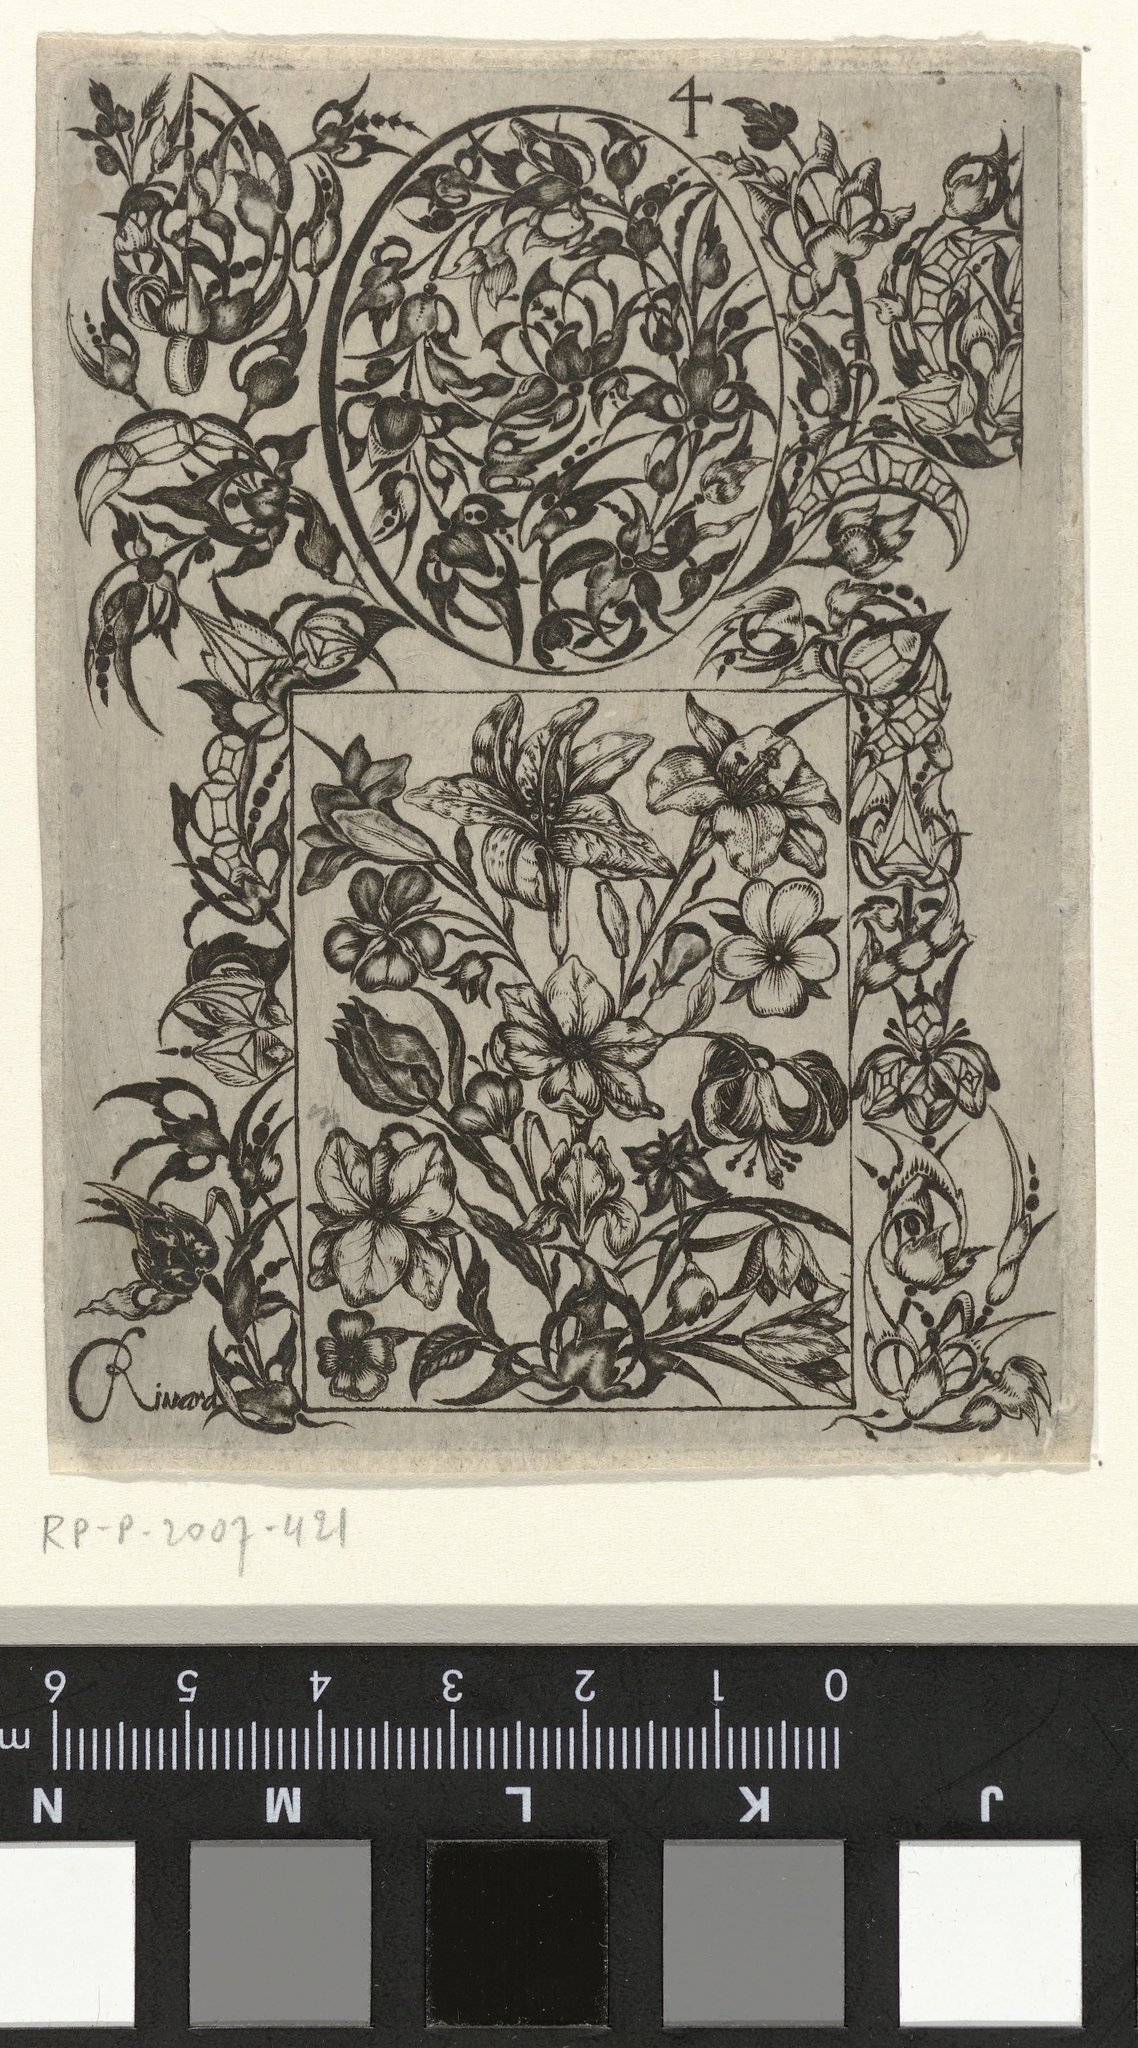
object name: ornament print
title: Cosse-de-pois en bloemenornamenten in een ovaal en een rechthoek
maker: claude rivard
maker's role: print maker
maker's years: 1592-1670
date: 1602-1670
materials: paper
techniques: engraving, etching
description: Fuhring, P. & Bimbenet-Privat, M., 'Le style "cosses de pois" : l'orfèvrerie et la gravure à Paris sous Louis XIII', nr. 370